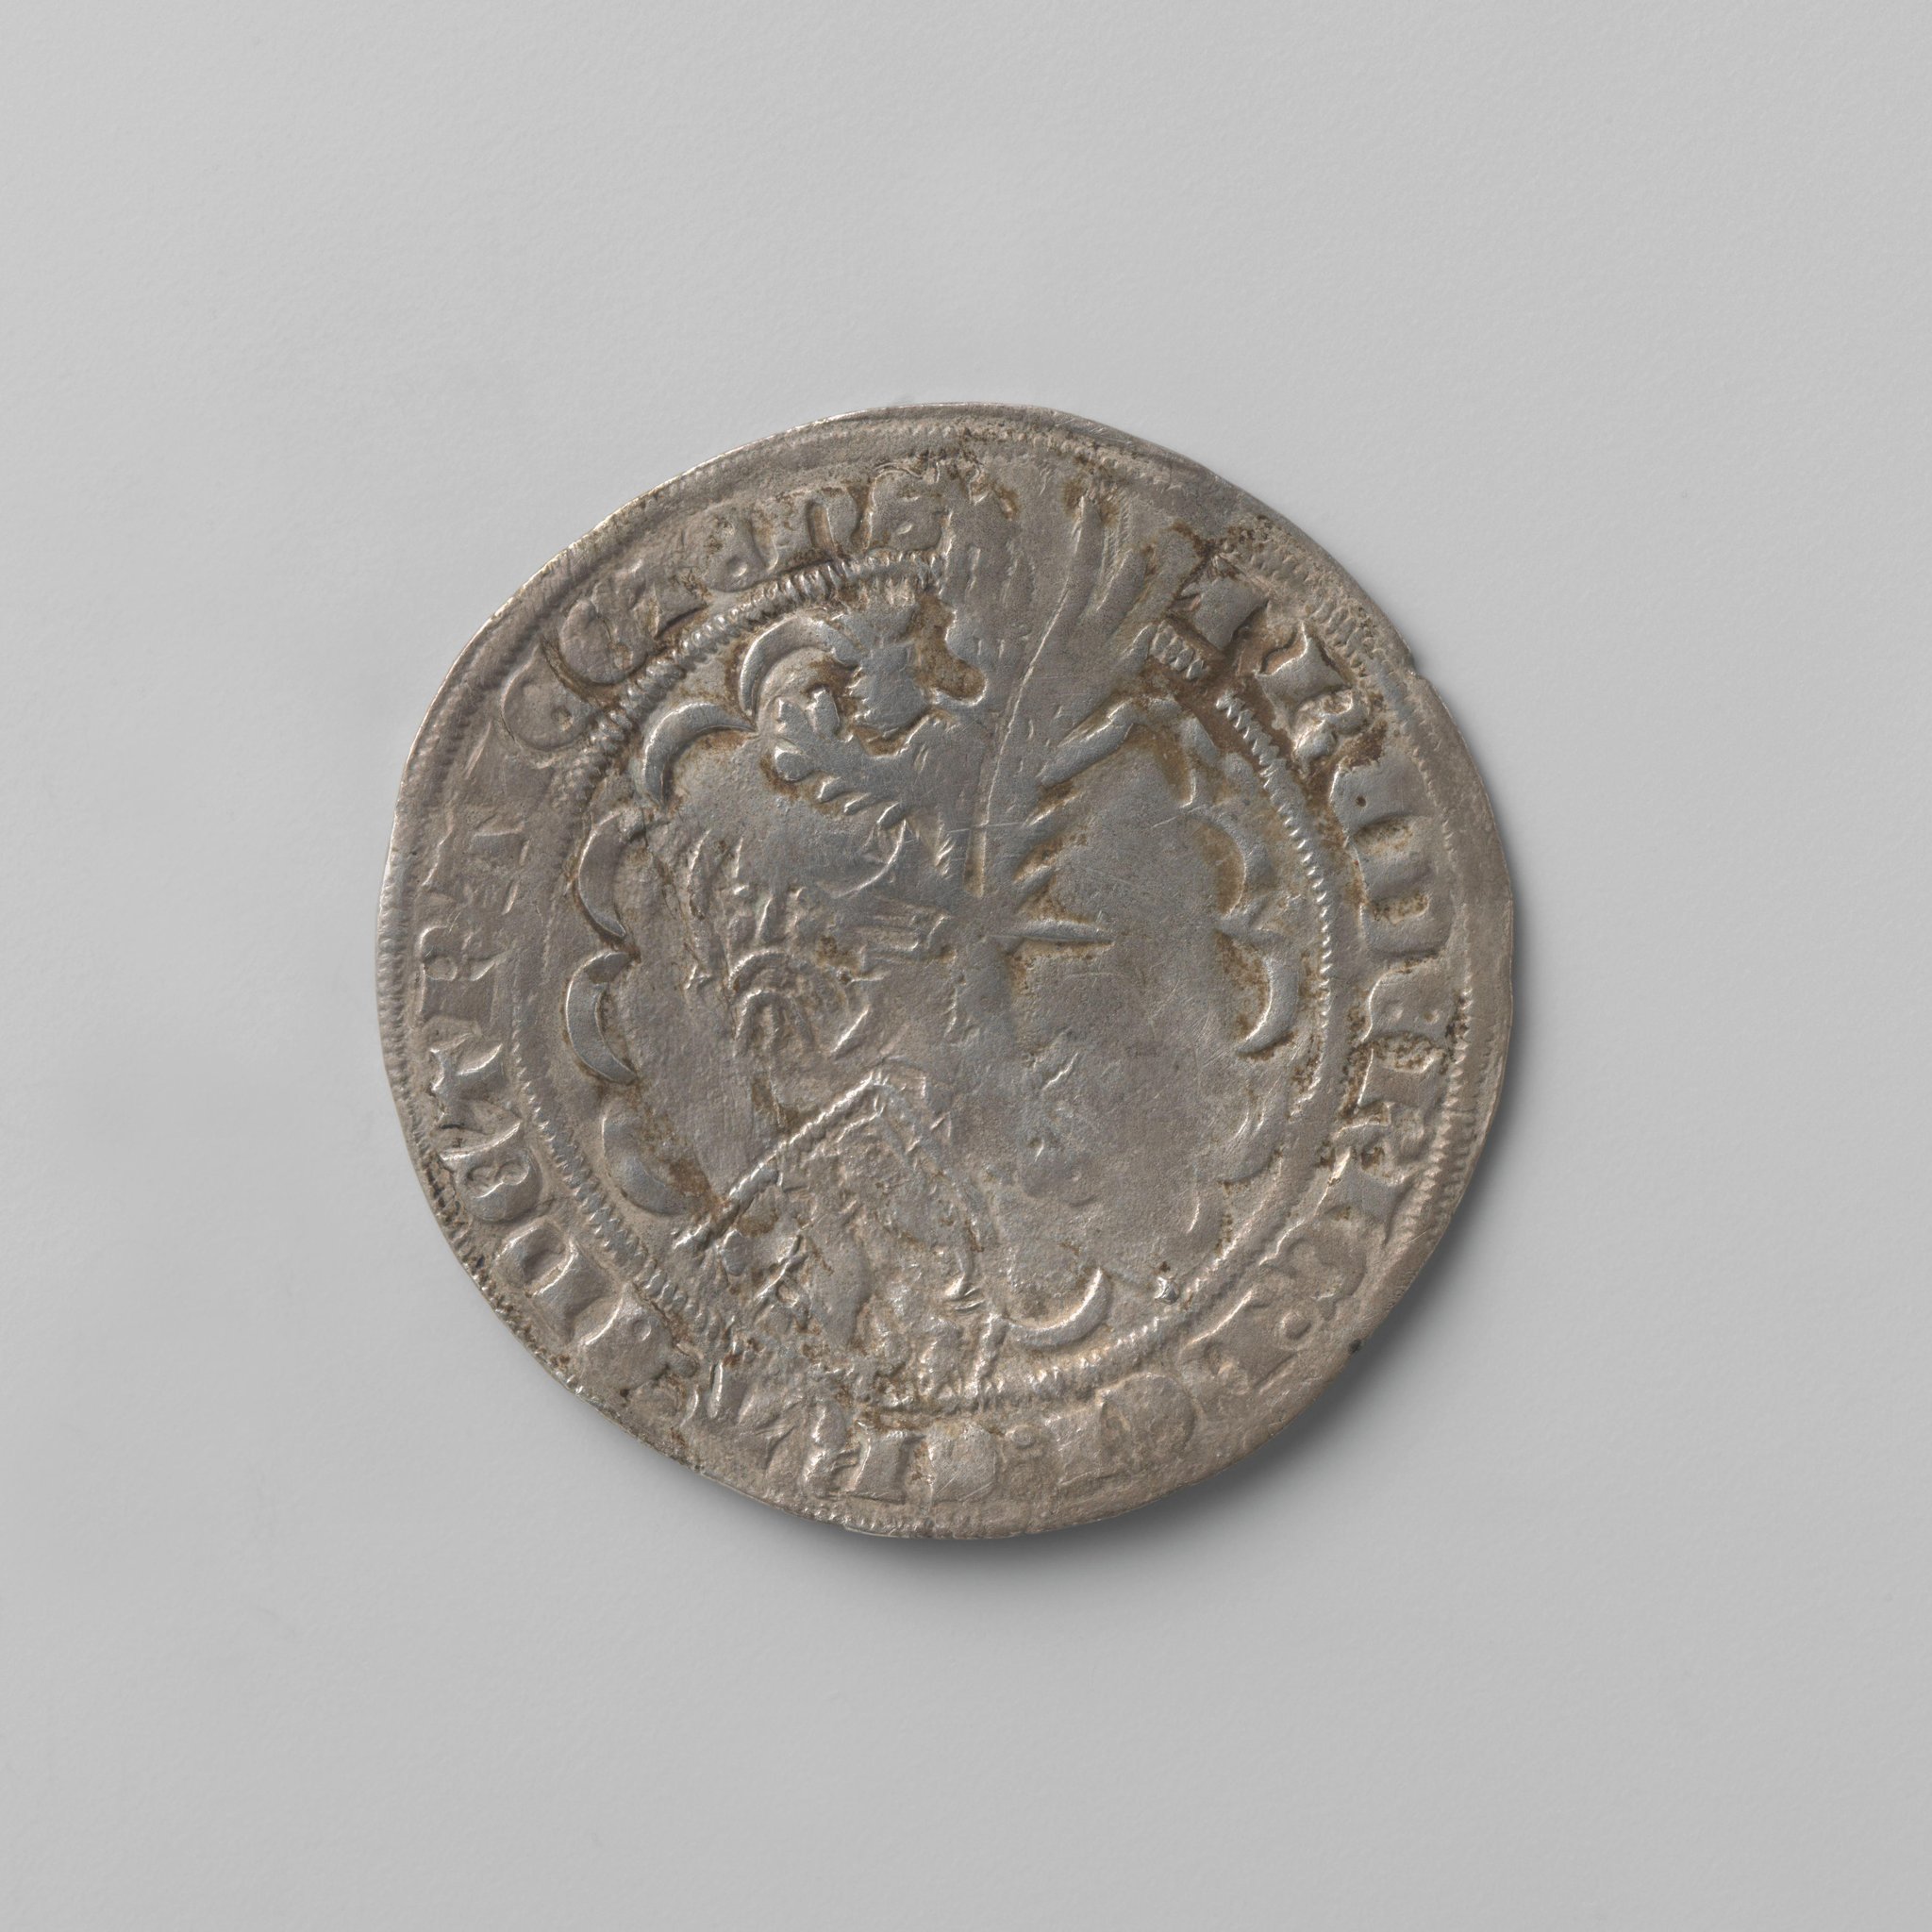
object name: coin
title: Utrecht, Frederik van Blankenheim, dubbele plak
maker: frederik van blankenheim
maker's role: bisschop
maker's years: 1355-1423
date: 1393-1423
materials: silver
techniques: striking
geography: deventer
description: Zilveren munt. Voorzijde: binnen veelpas gehelmd schuin geplaatst wapenschild van Blankenheim. Keerzijde: adelaar met onder zijn poten wapenschild van Utrecht. Dubbel omschrift. Klop van Munster (Pauluskop).